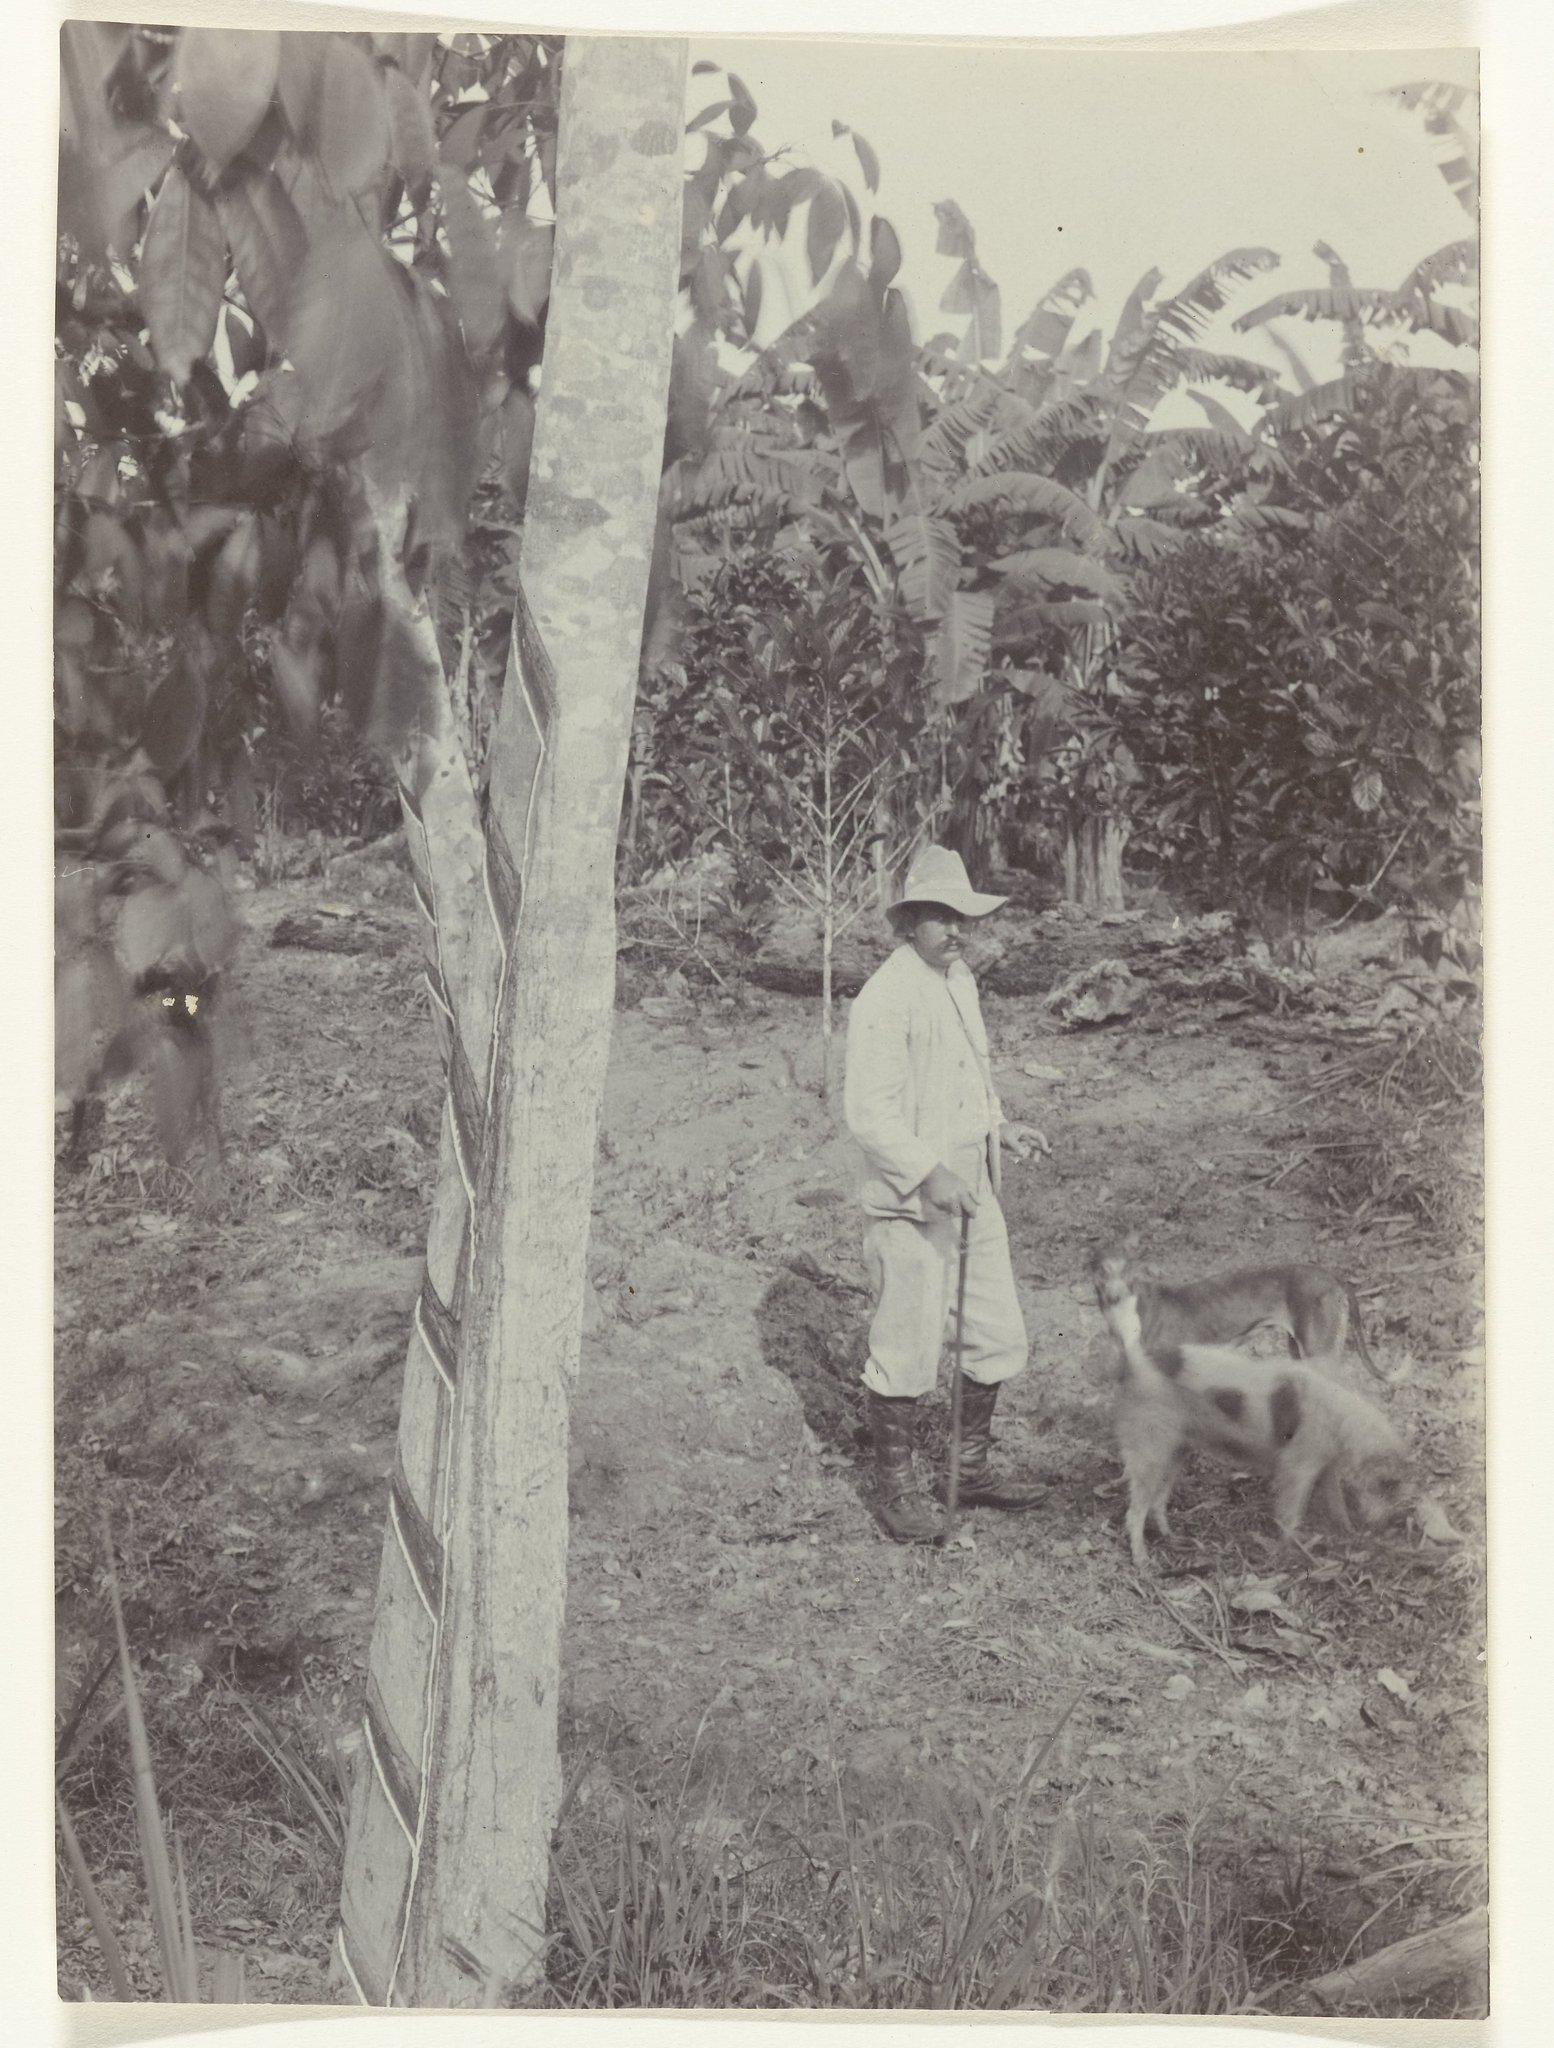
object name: photograph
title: Plantage-eigenaar met honden op plantage Accaribo te Suriname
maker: theodoor brouwers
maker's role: amateurfotograaf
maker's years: 1874-1932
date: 1916-1930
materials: photographic support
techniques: photography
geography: suriname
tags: amsterdam, theodoor brouwers, plantation, suriname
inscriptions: inscription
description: In de periode 1911-1932 woonde op plantage Accaribo in Suriname de familie Brouwers van wie de foto's afkomstig zijn. Rond 1910 vond Theodoor Brouwers werk op plantage Accaribo. In 1929 werd hij eigenaar van de plantage.